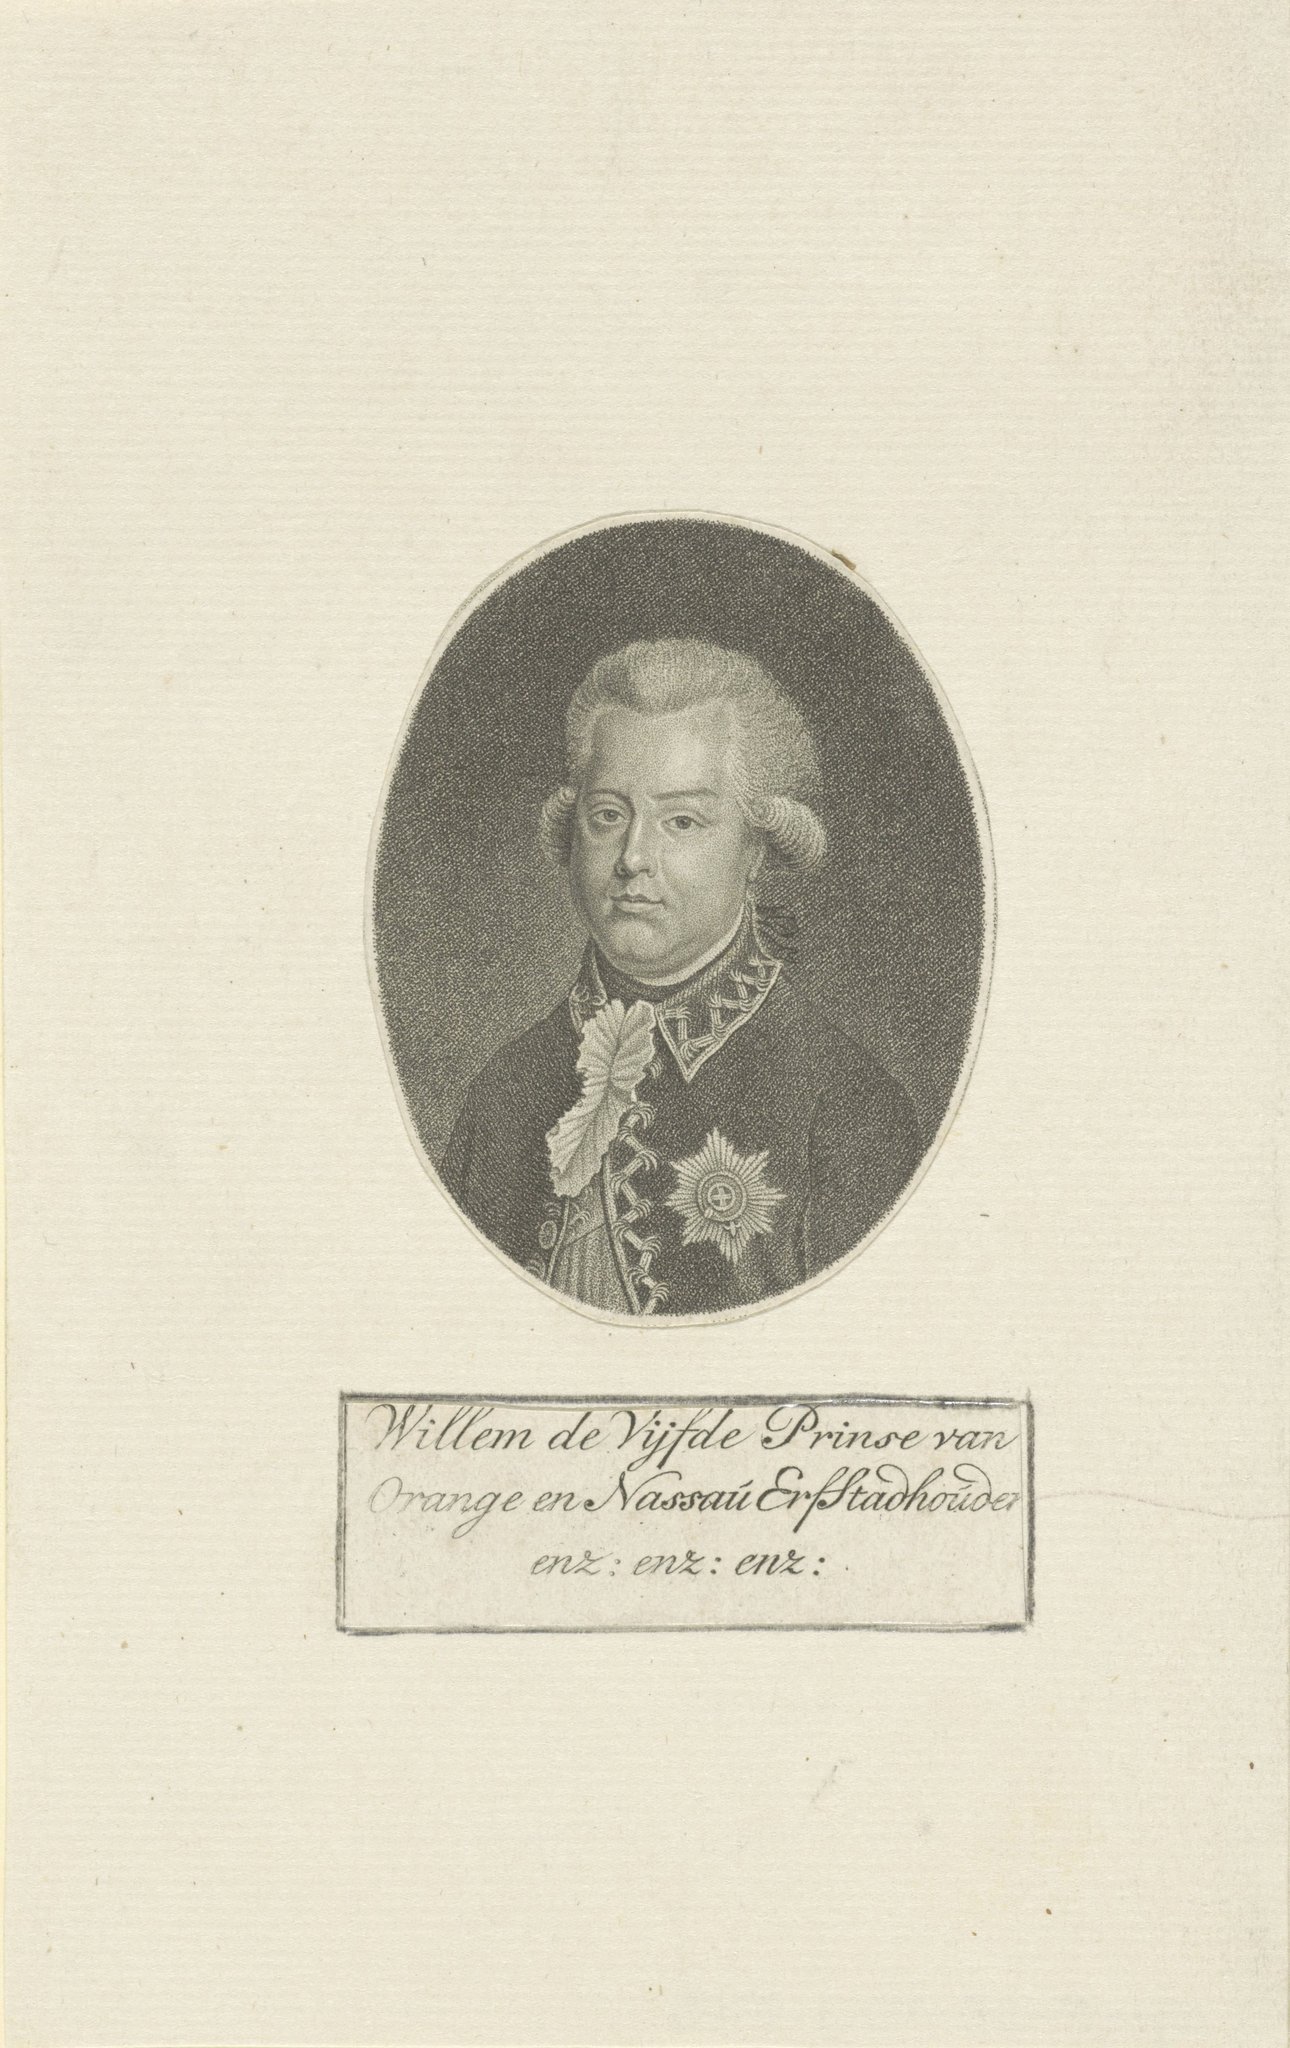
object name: print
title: Portret van Willem V, prins van Oranje-Nassau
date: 1781-1801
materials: paper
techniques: engraving, etching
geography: the hague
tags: the hague, william v (prince of orange), knighthood order (garter) - insignia of a knighthood order, e.g.: badge, chain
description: De hier vermelde titel verwijst naar de hoogst verkregen titel van de geportretteerde, niet per se naar de titel die de geportretteerde op deze voorstelling draagt.